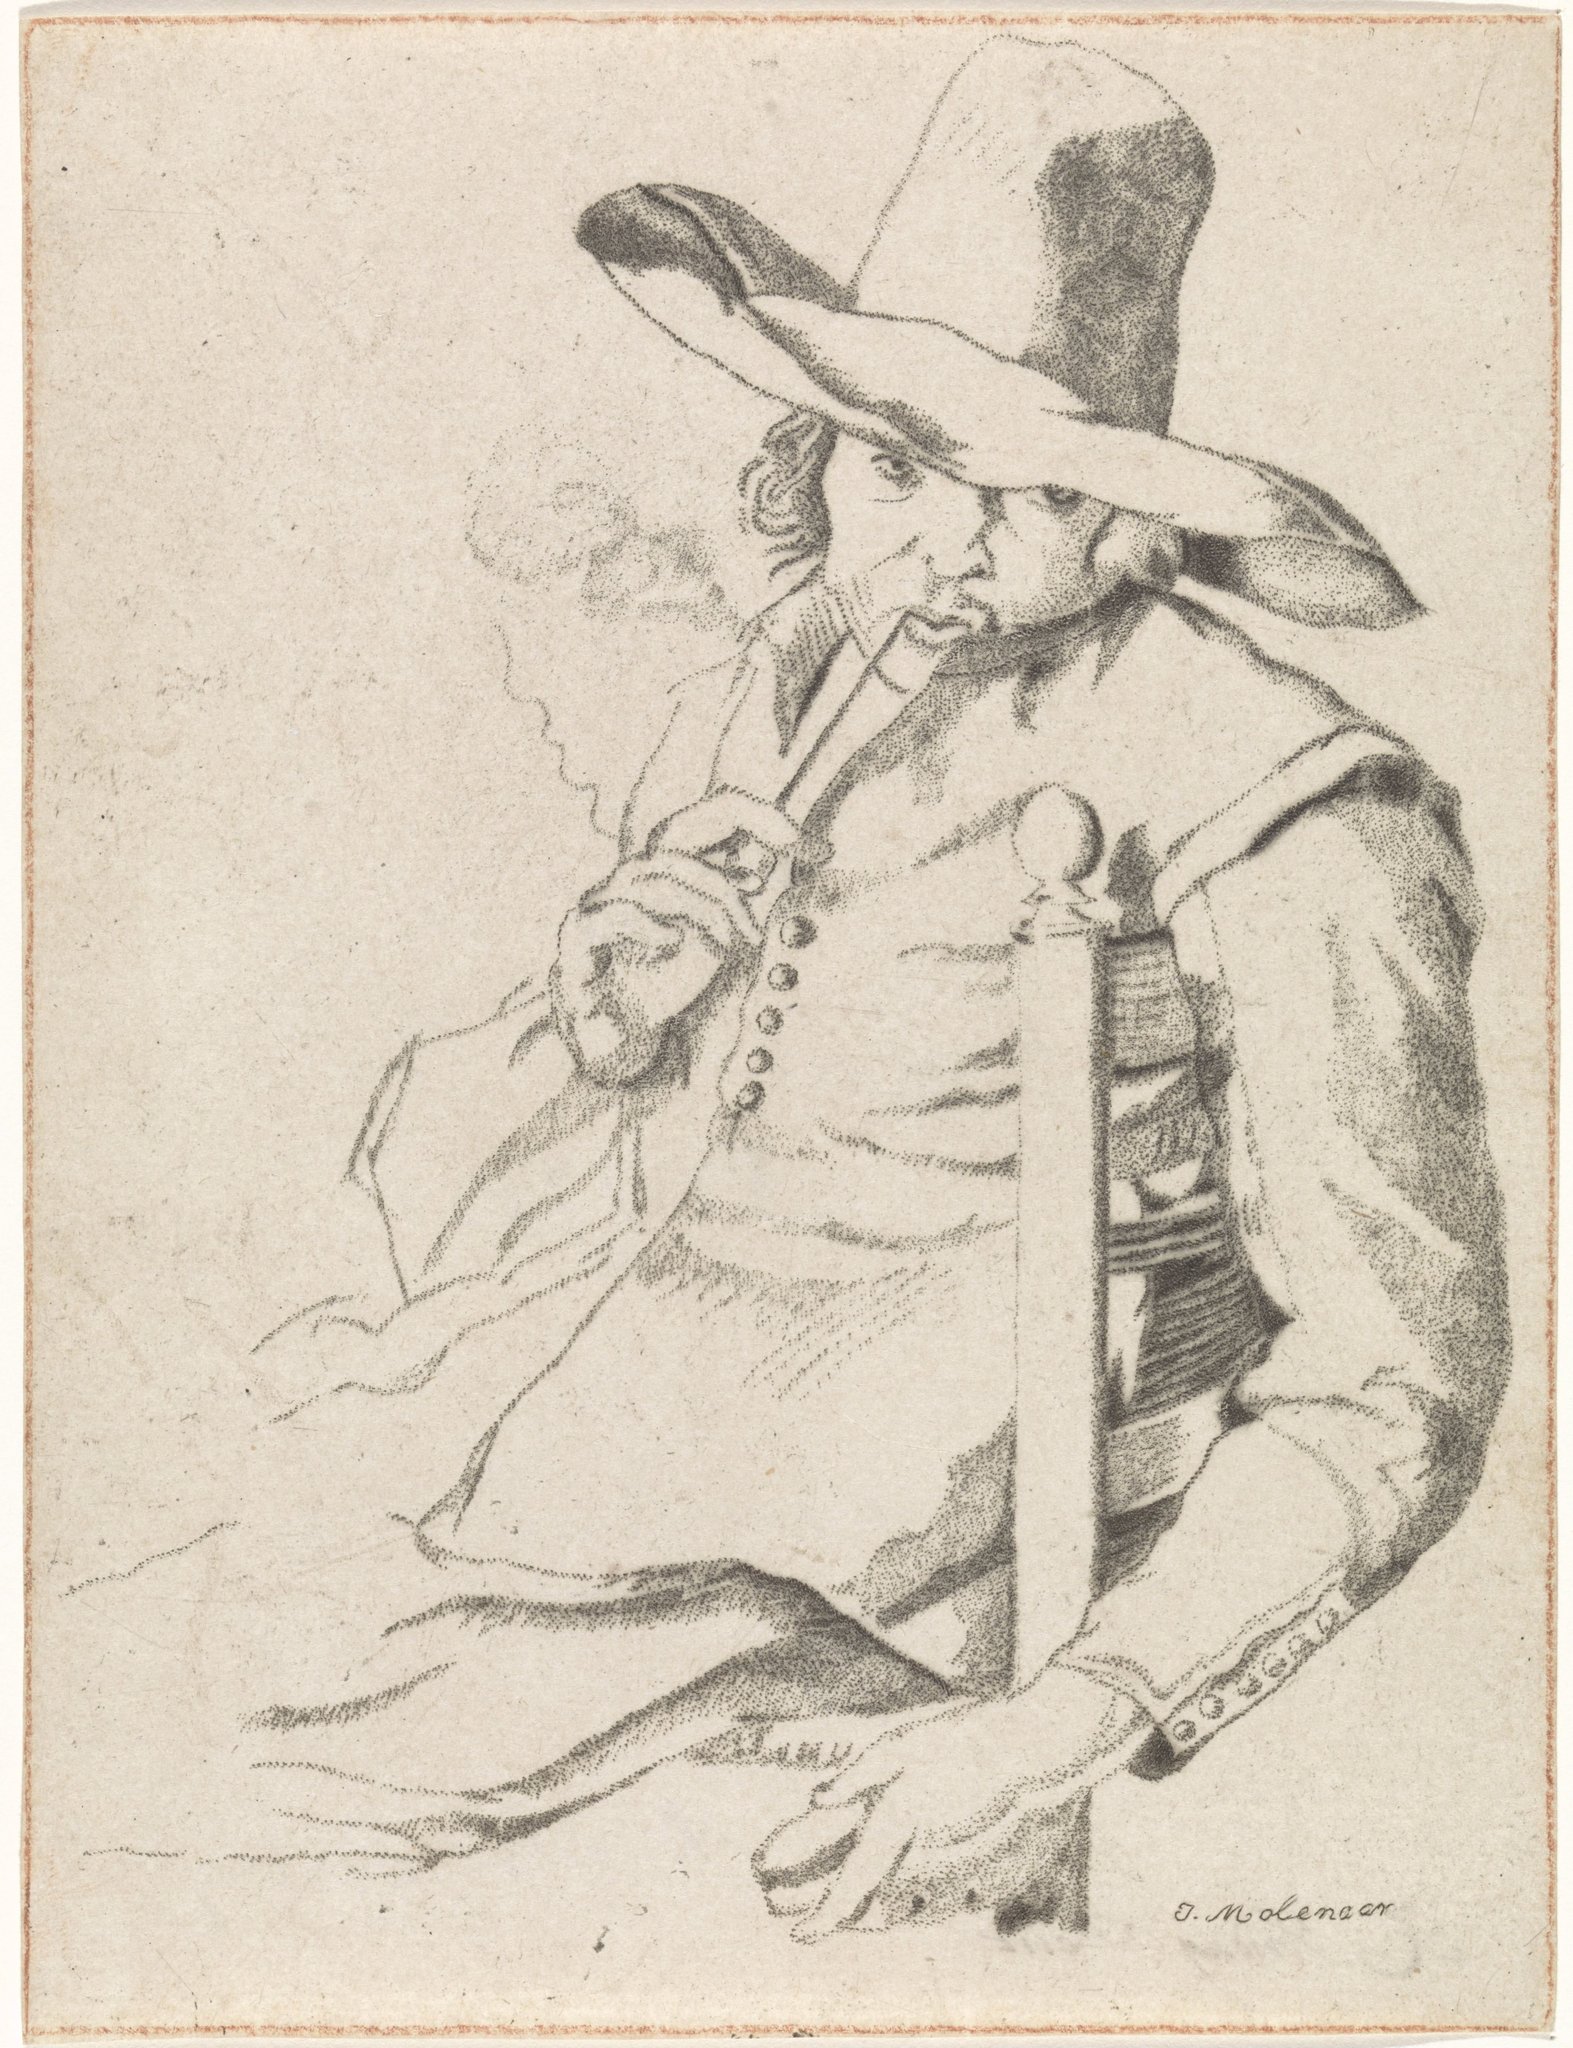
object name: print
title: Pijp rokende man met hoge hoed op een stoel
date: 1741-1812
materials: chalk, paper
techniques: intaglio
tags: pipe ~ tobacco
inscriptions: collector's mark: Lugt 2228, collector's mark: Lugt 2760, inscription: ‘R Sondag Fecit’